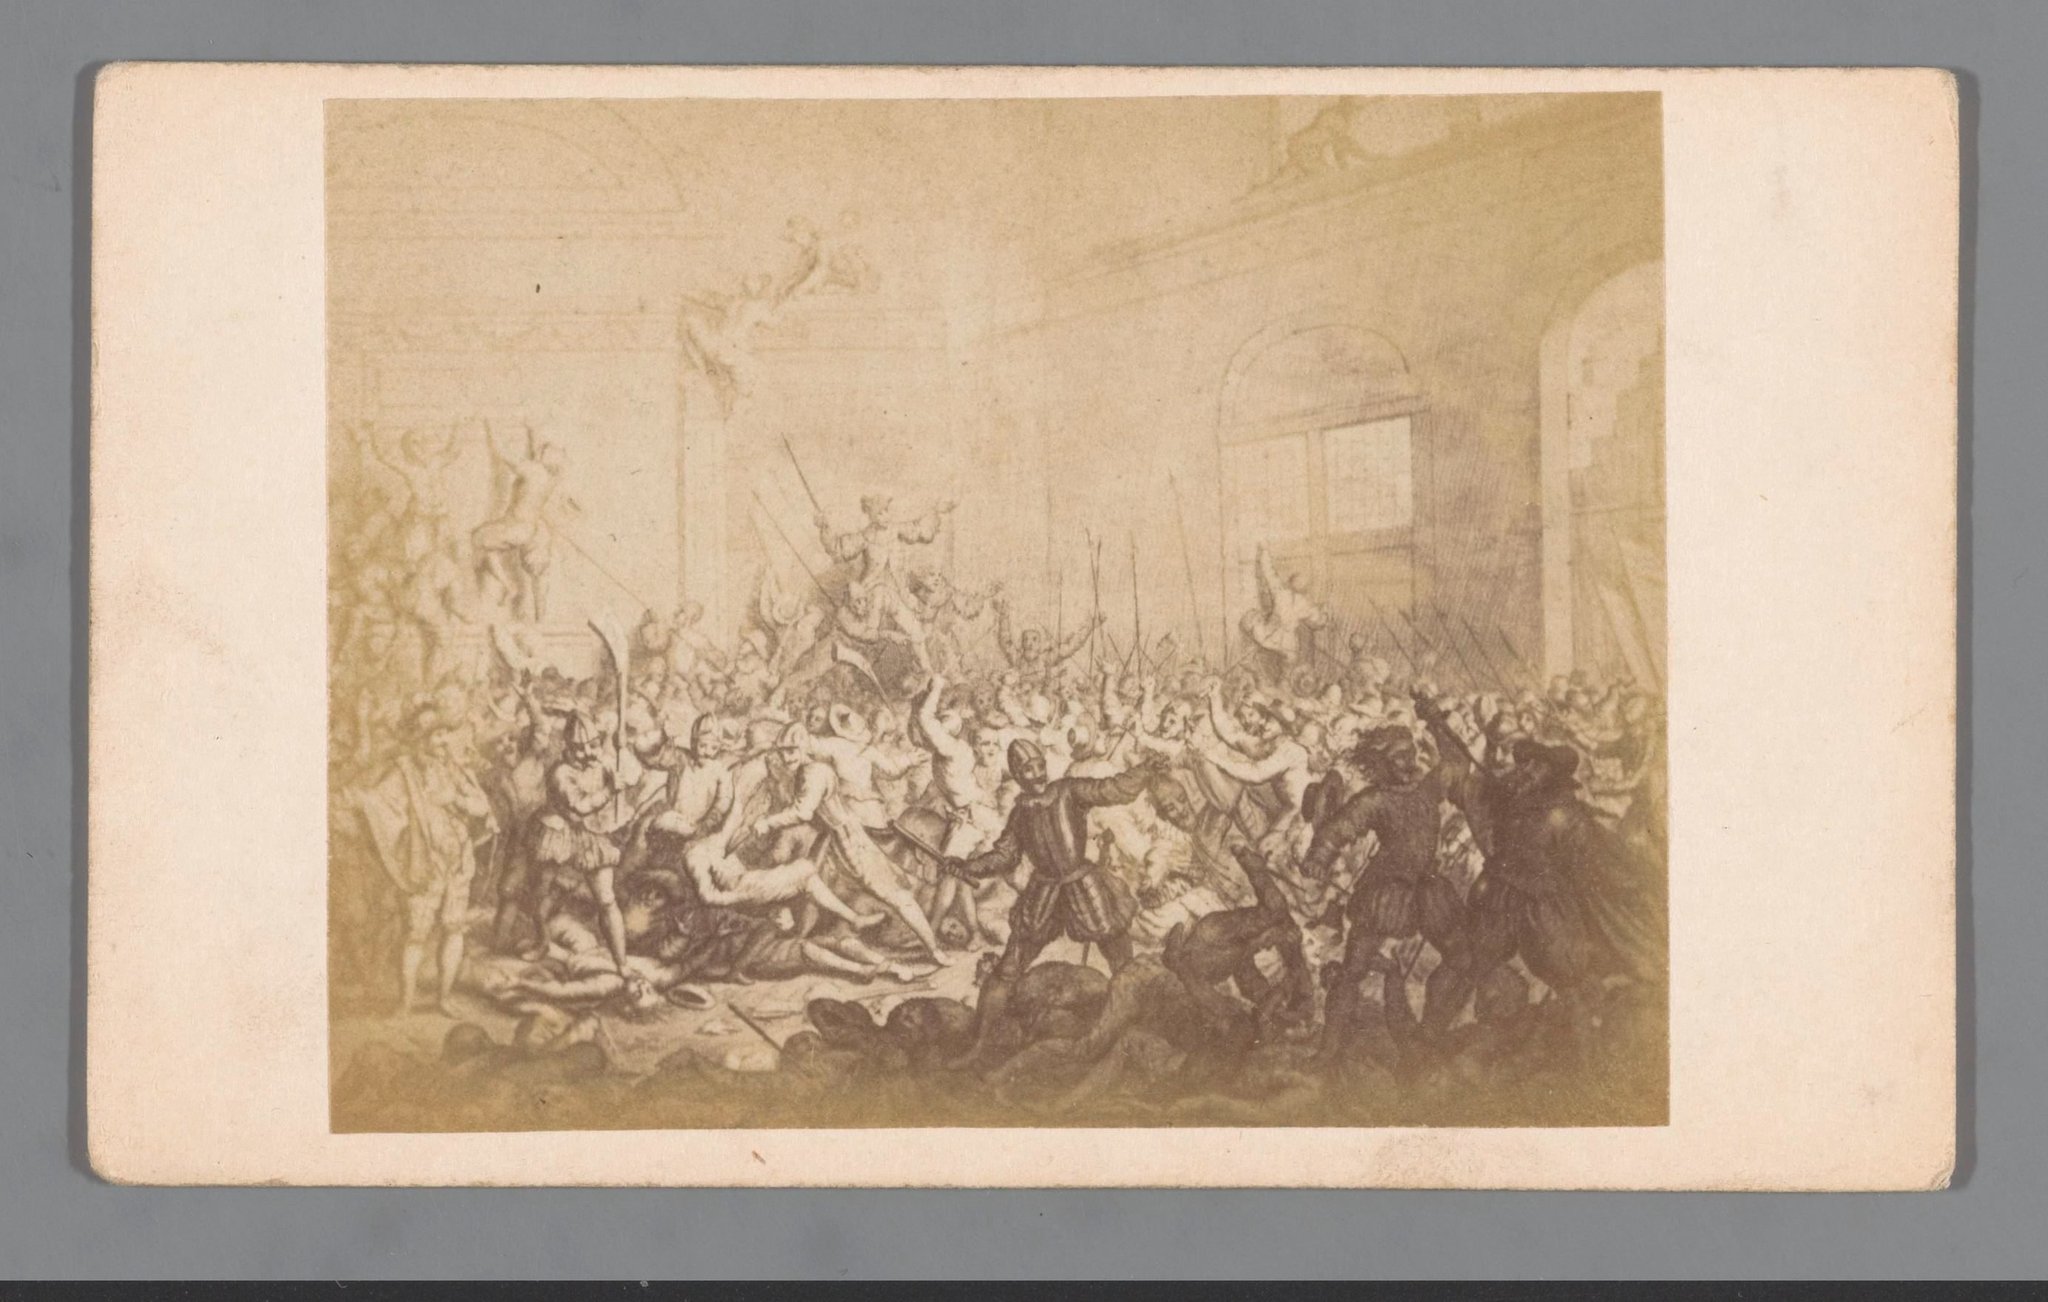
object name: reproduction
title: Fotoreproductie van een gravure van moordpartij door de Spanjaarden in de kerk van Naarden op 1 december 1572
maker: Anonymous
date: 1850-1900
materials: cardboard, photographic support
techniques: albumen print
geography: netherlands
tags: interior of church, murder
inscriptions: inscription: ‘Moord door (...) letterlijk uitgemoord.’, number: ‘16’